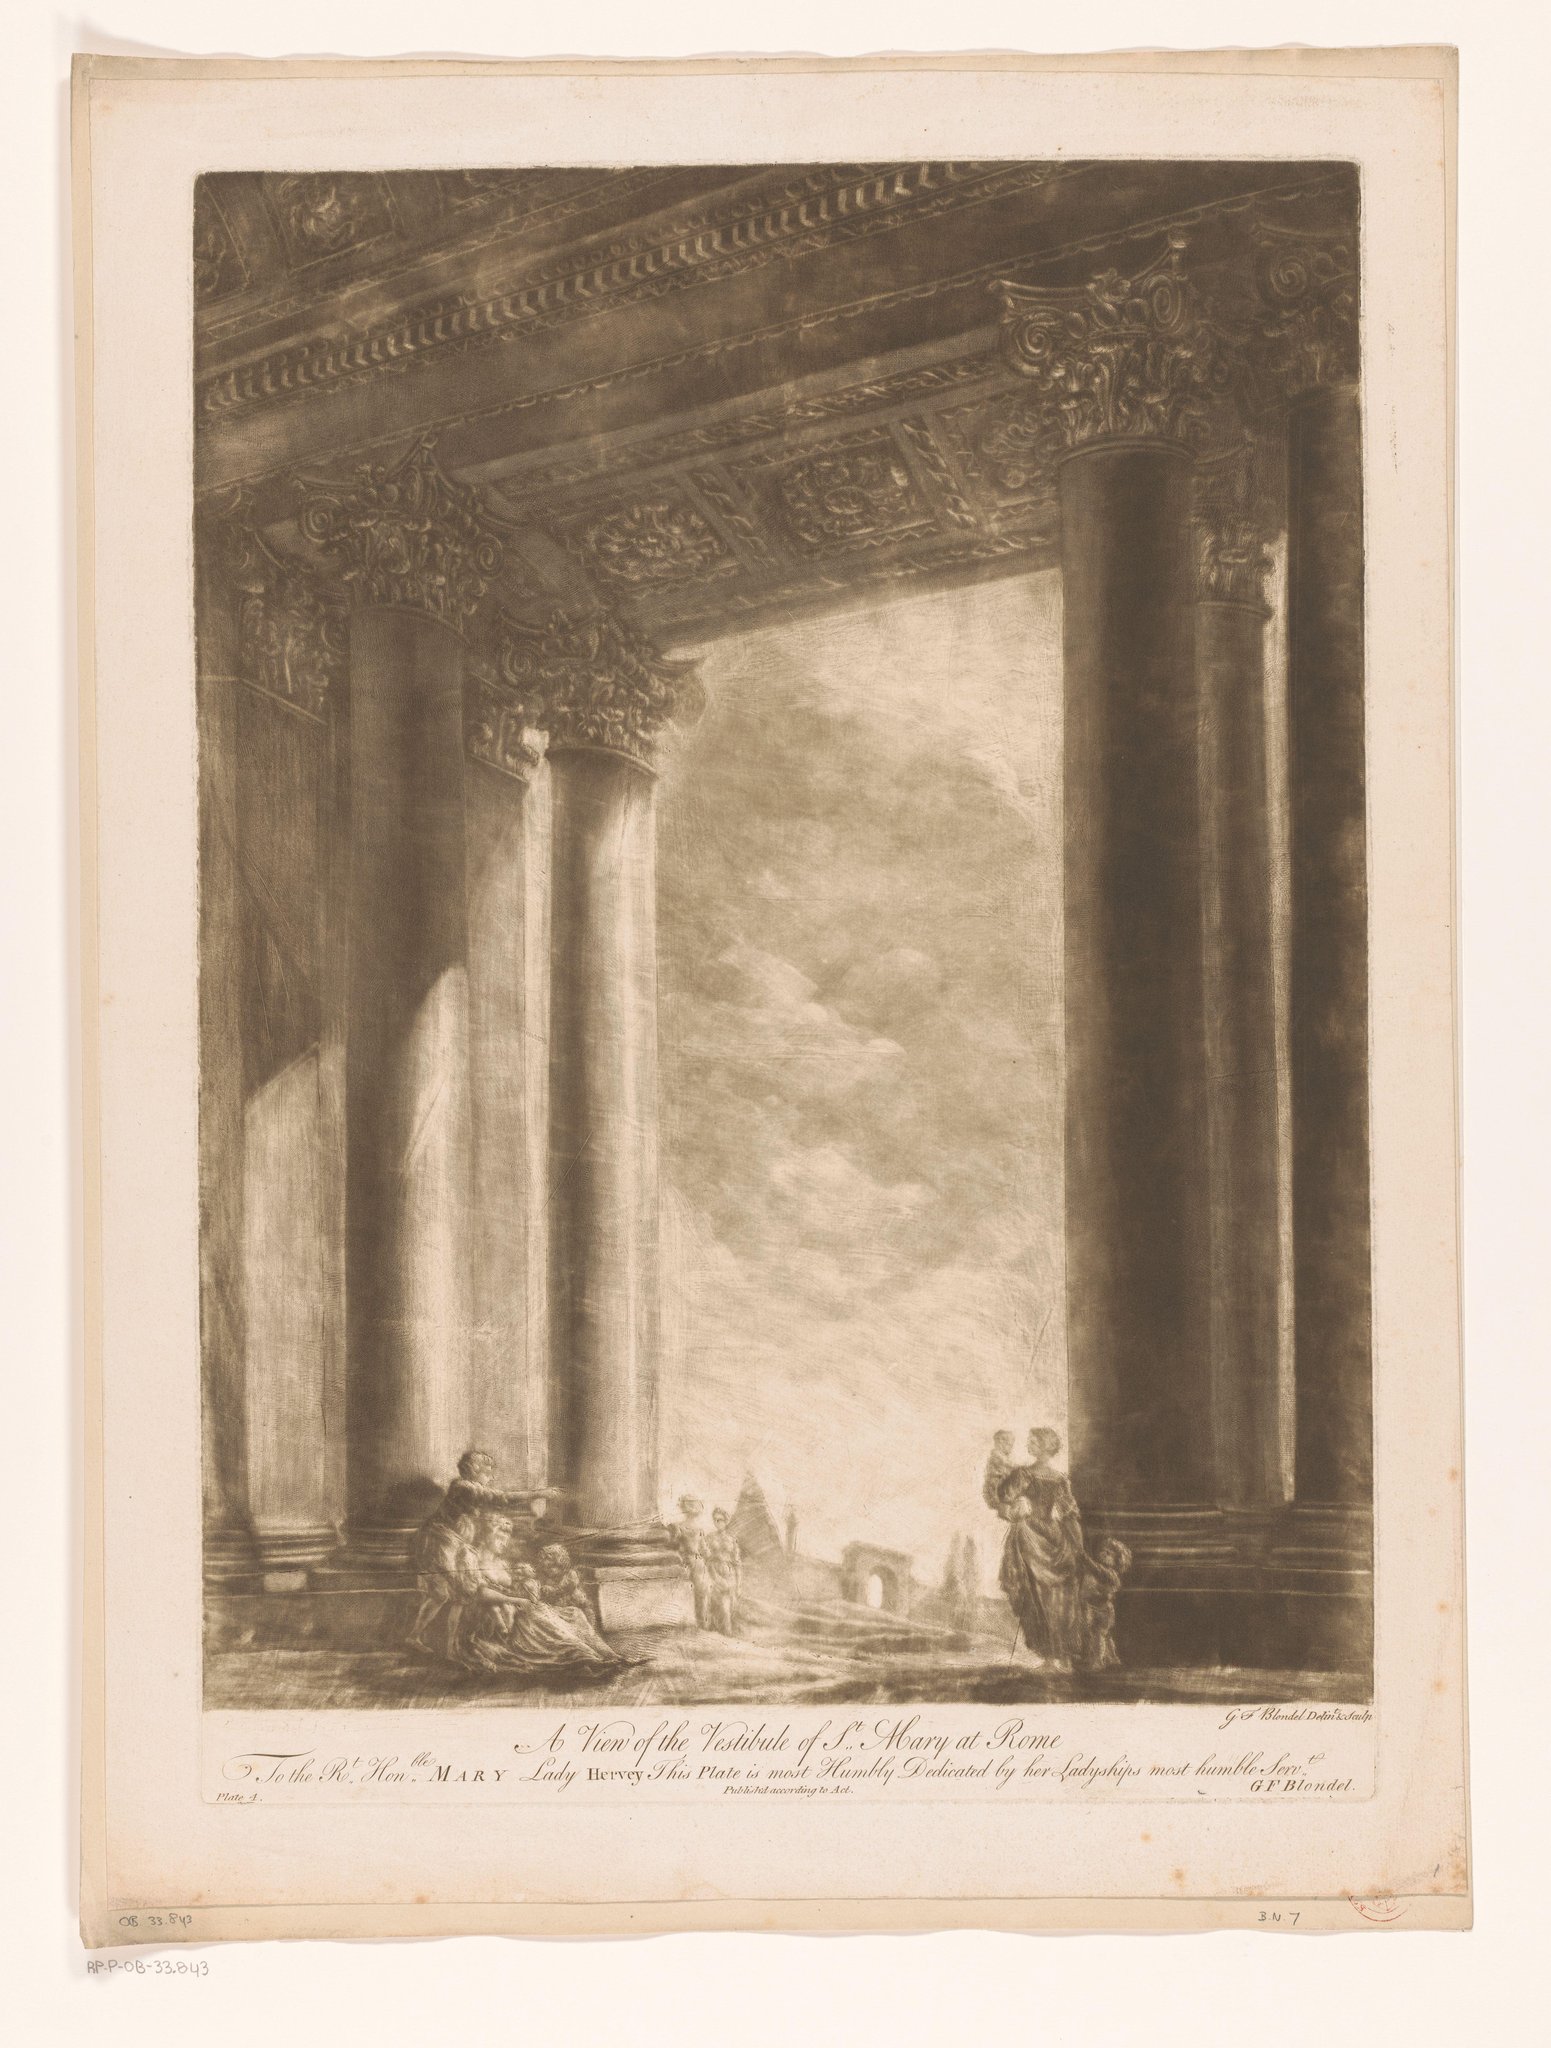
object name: print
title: Interieurs van gebouwen in Rome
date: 1765-1767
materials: paper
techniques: mezzotint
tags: interior of church, rome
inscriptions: collector's mark: Lugt 240